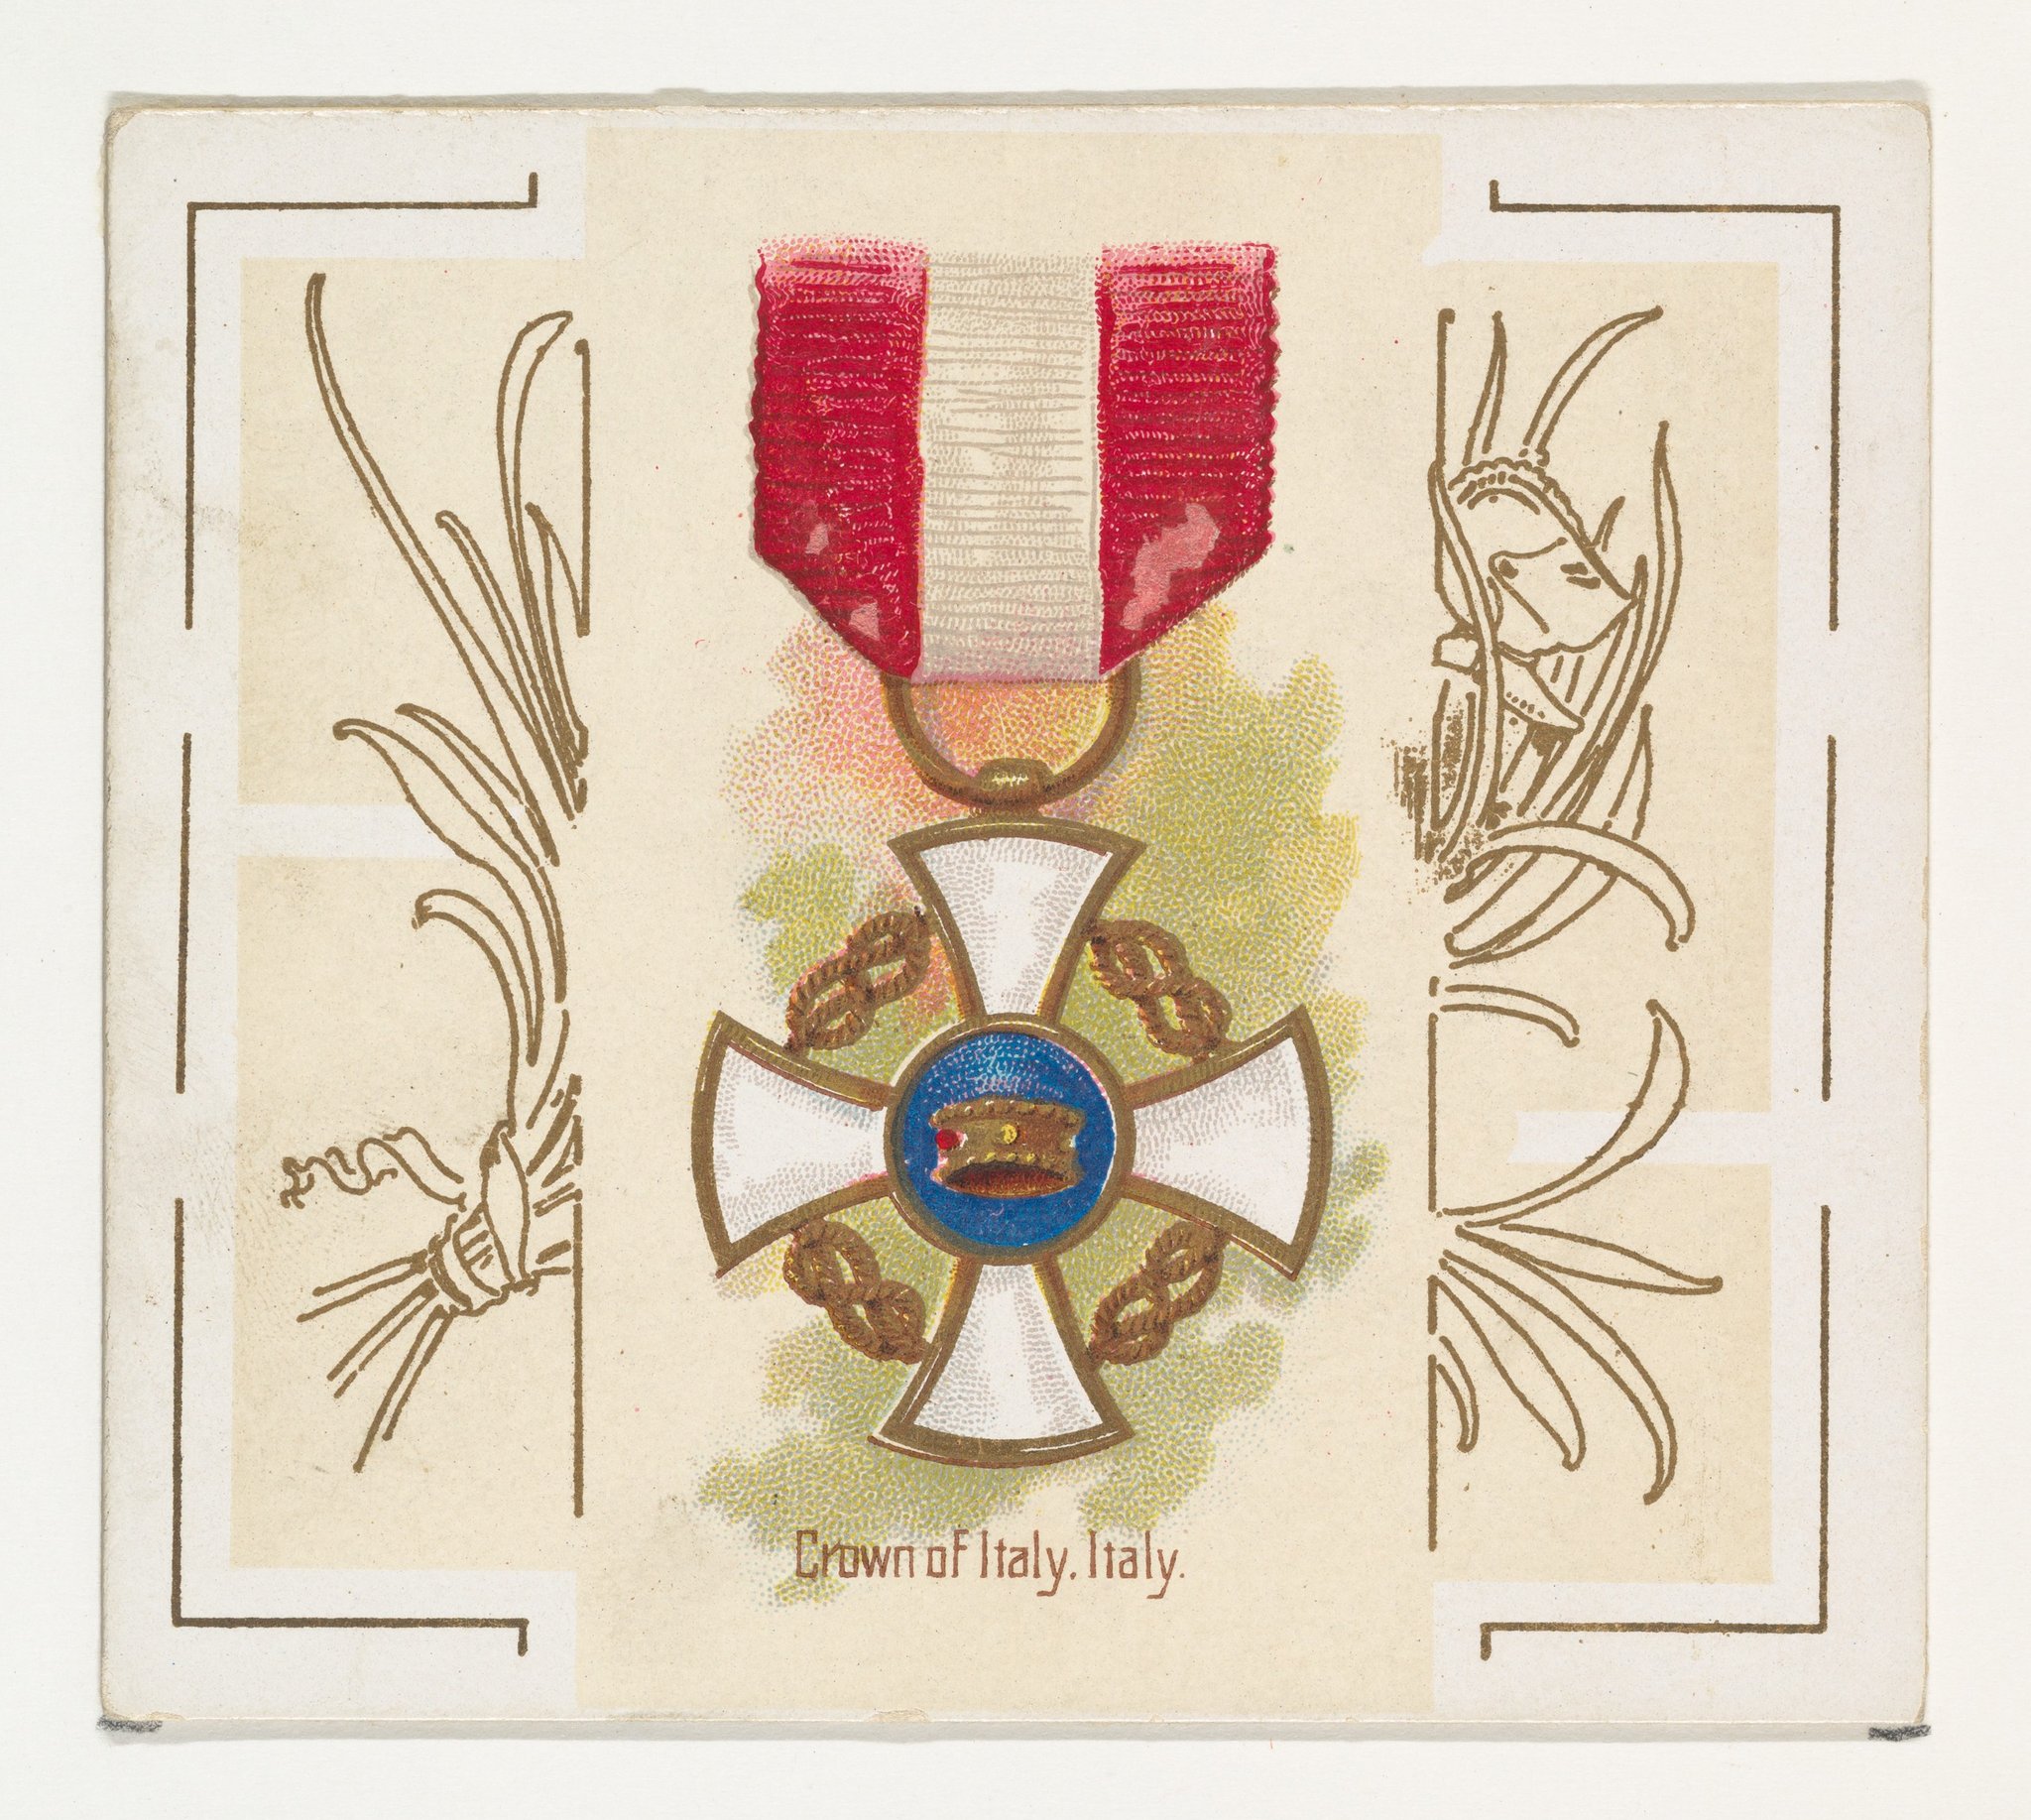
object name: print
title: Crown of Italy, Italy, from the World's Decorations series (N44) for Allen & Ginter Cigarettes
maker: allen & ginter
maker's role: publisher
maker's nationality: american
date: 1890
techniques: color lithograph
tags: medals